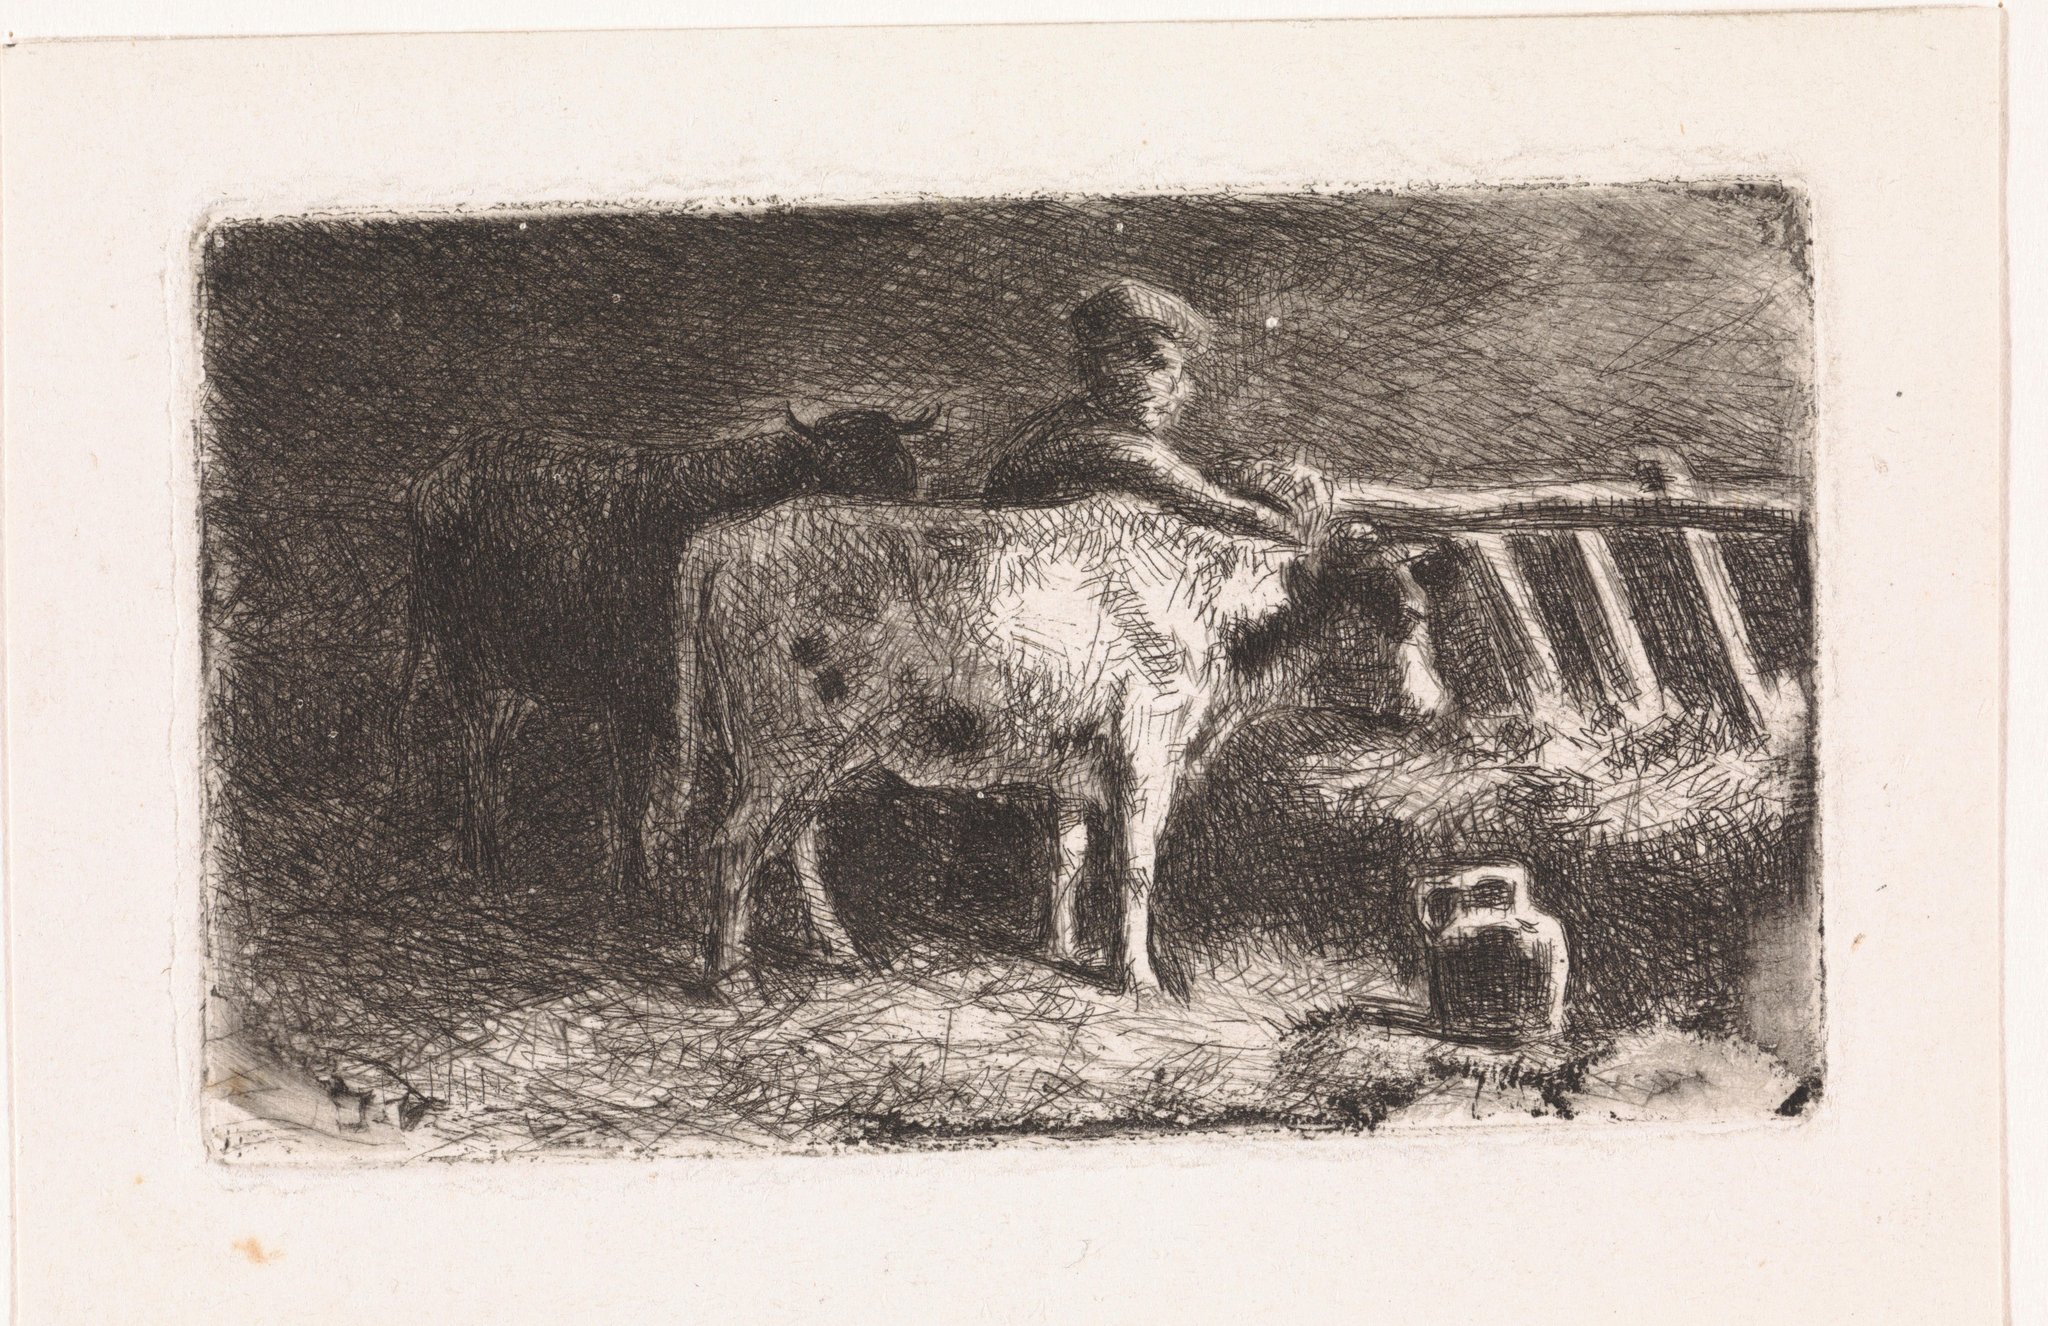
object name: print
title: Boer tussen twee koeien bij een ruif in een stal (kleine variant)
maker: jan vrolijk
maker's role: draughtsman, painter, print maker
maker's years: 1846-1894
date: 1860-1894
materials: paper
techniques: drypoint, etching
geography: the hague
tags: cow, farmers, stall, stable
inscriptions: collector's mark: Lugt 2228